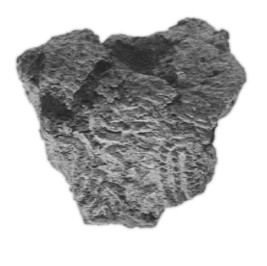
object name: sealing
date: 2030-1640 BCE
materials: clay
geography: egypt